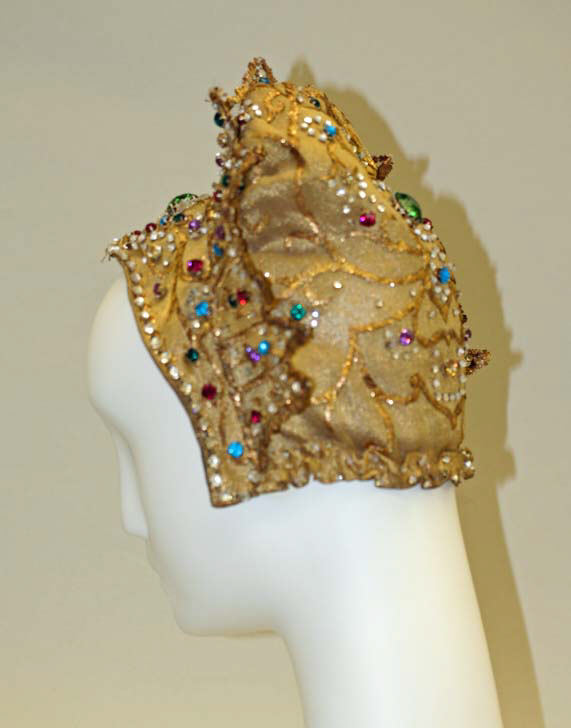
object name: cap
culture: french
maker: félix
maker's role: design house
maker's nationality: french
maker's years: 1846-1901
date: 1890-1909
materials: glass, metal